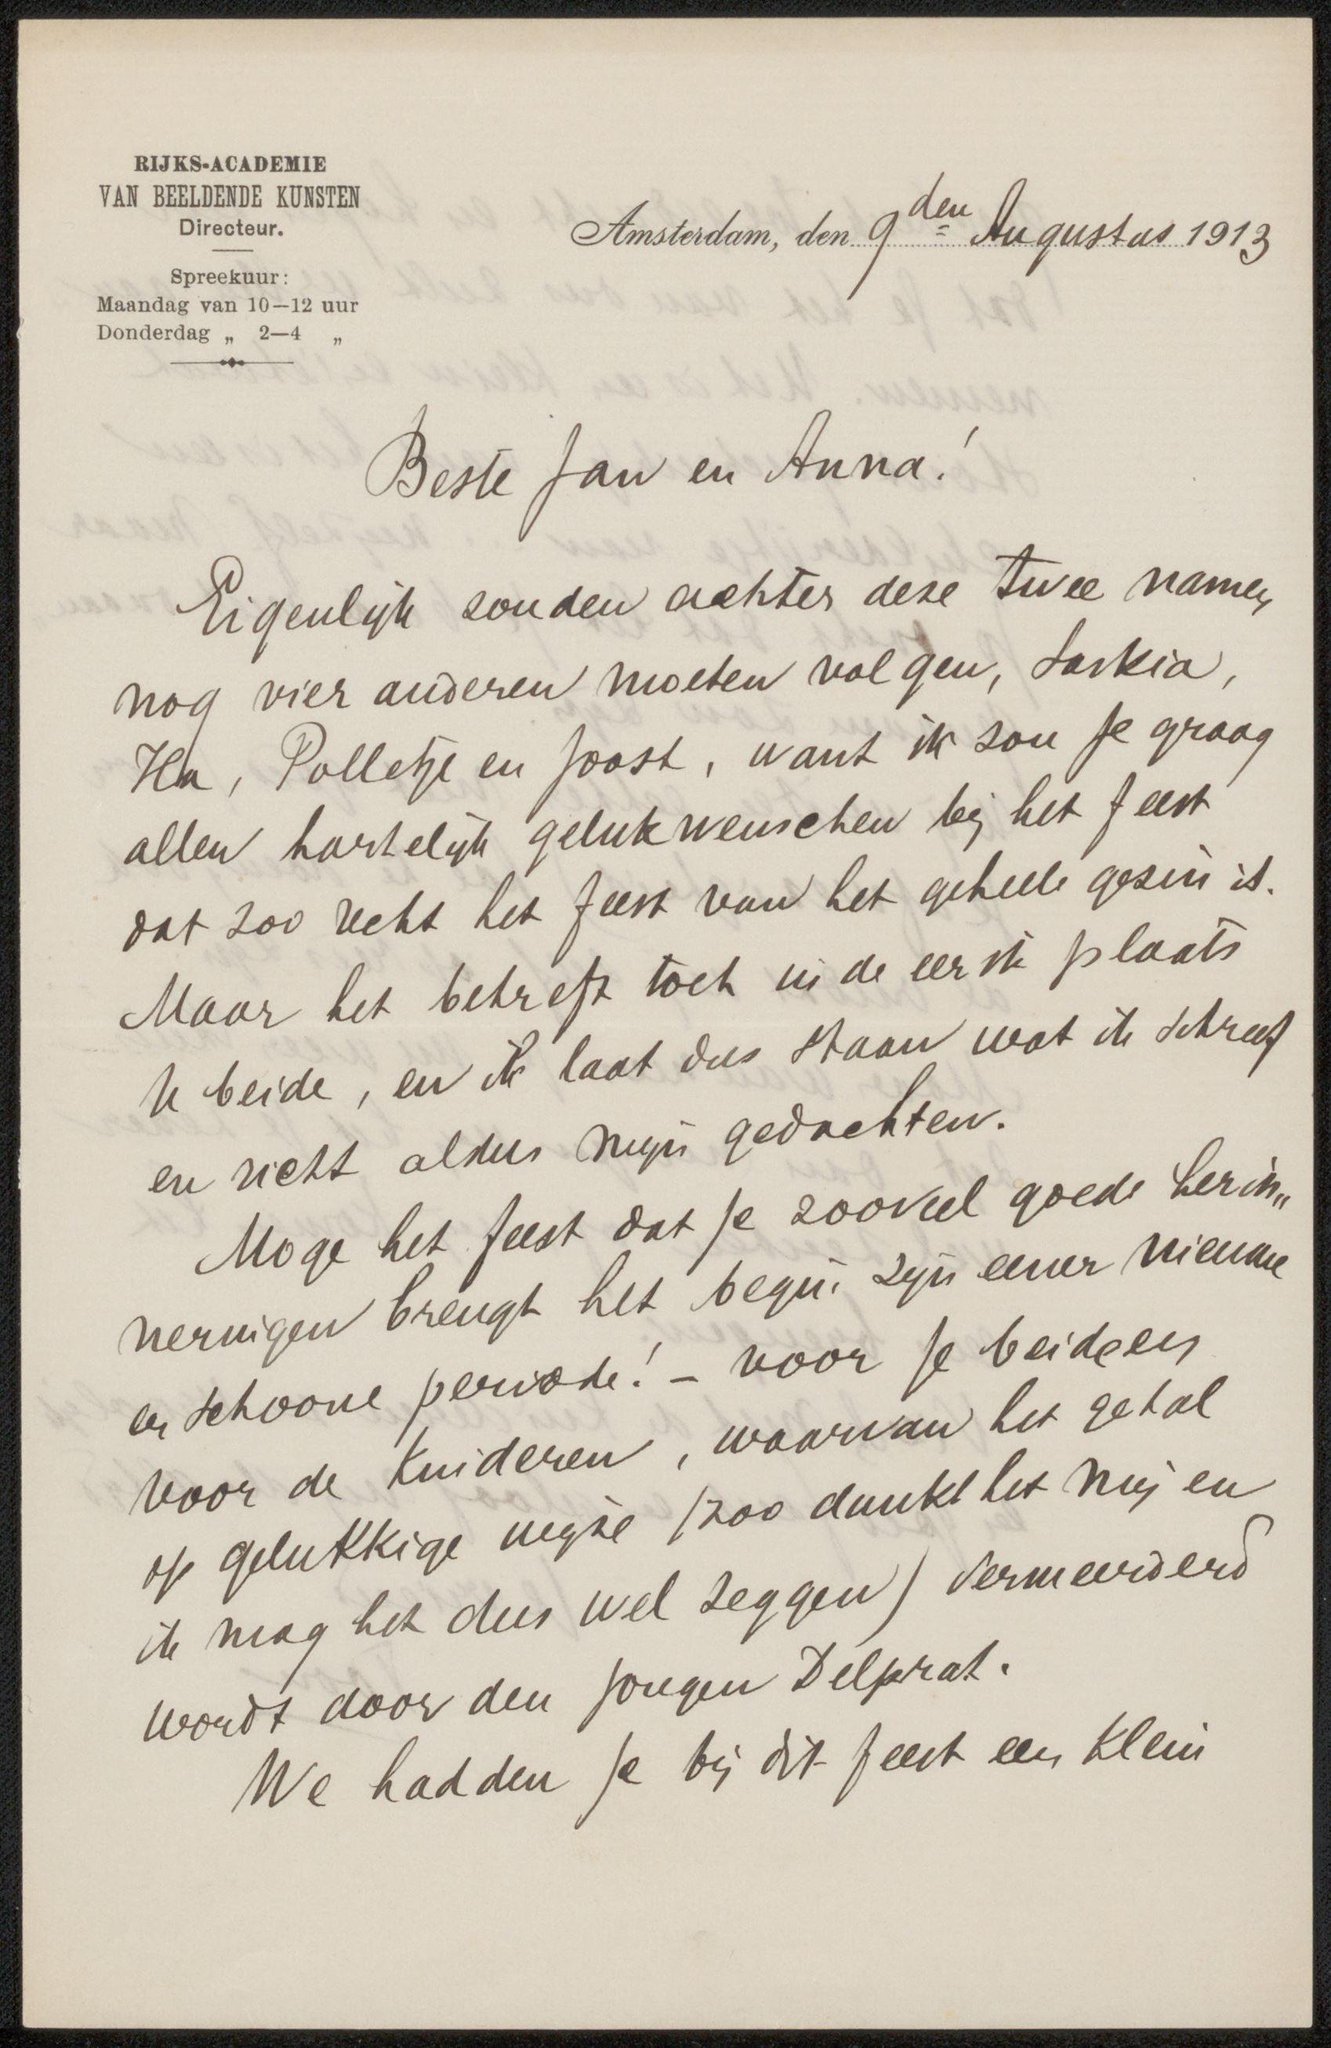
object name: letter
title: Brief aan Jan Veth en Anna Dorothea Dirks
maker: antoon derkinderen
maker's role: draughtsman, painter, print maker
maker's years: 1859-1925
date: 1913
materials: ink, paper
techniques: pen, printing, writing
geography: amsterdam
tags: dordrecht, amsterdam, painter, draughtsman, designer, jan veth, artist, anna dorothea dirks, family life, painting (including book-illumination, miniature-painting)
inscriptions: collector's mark: ‘RPK’